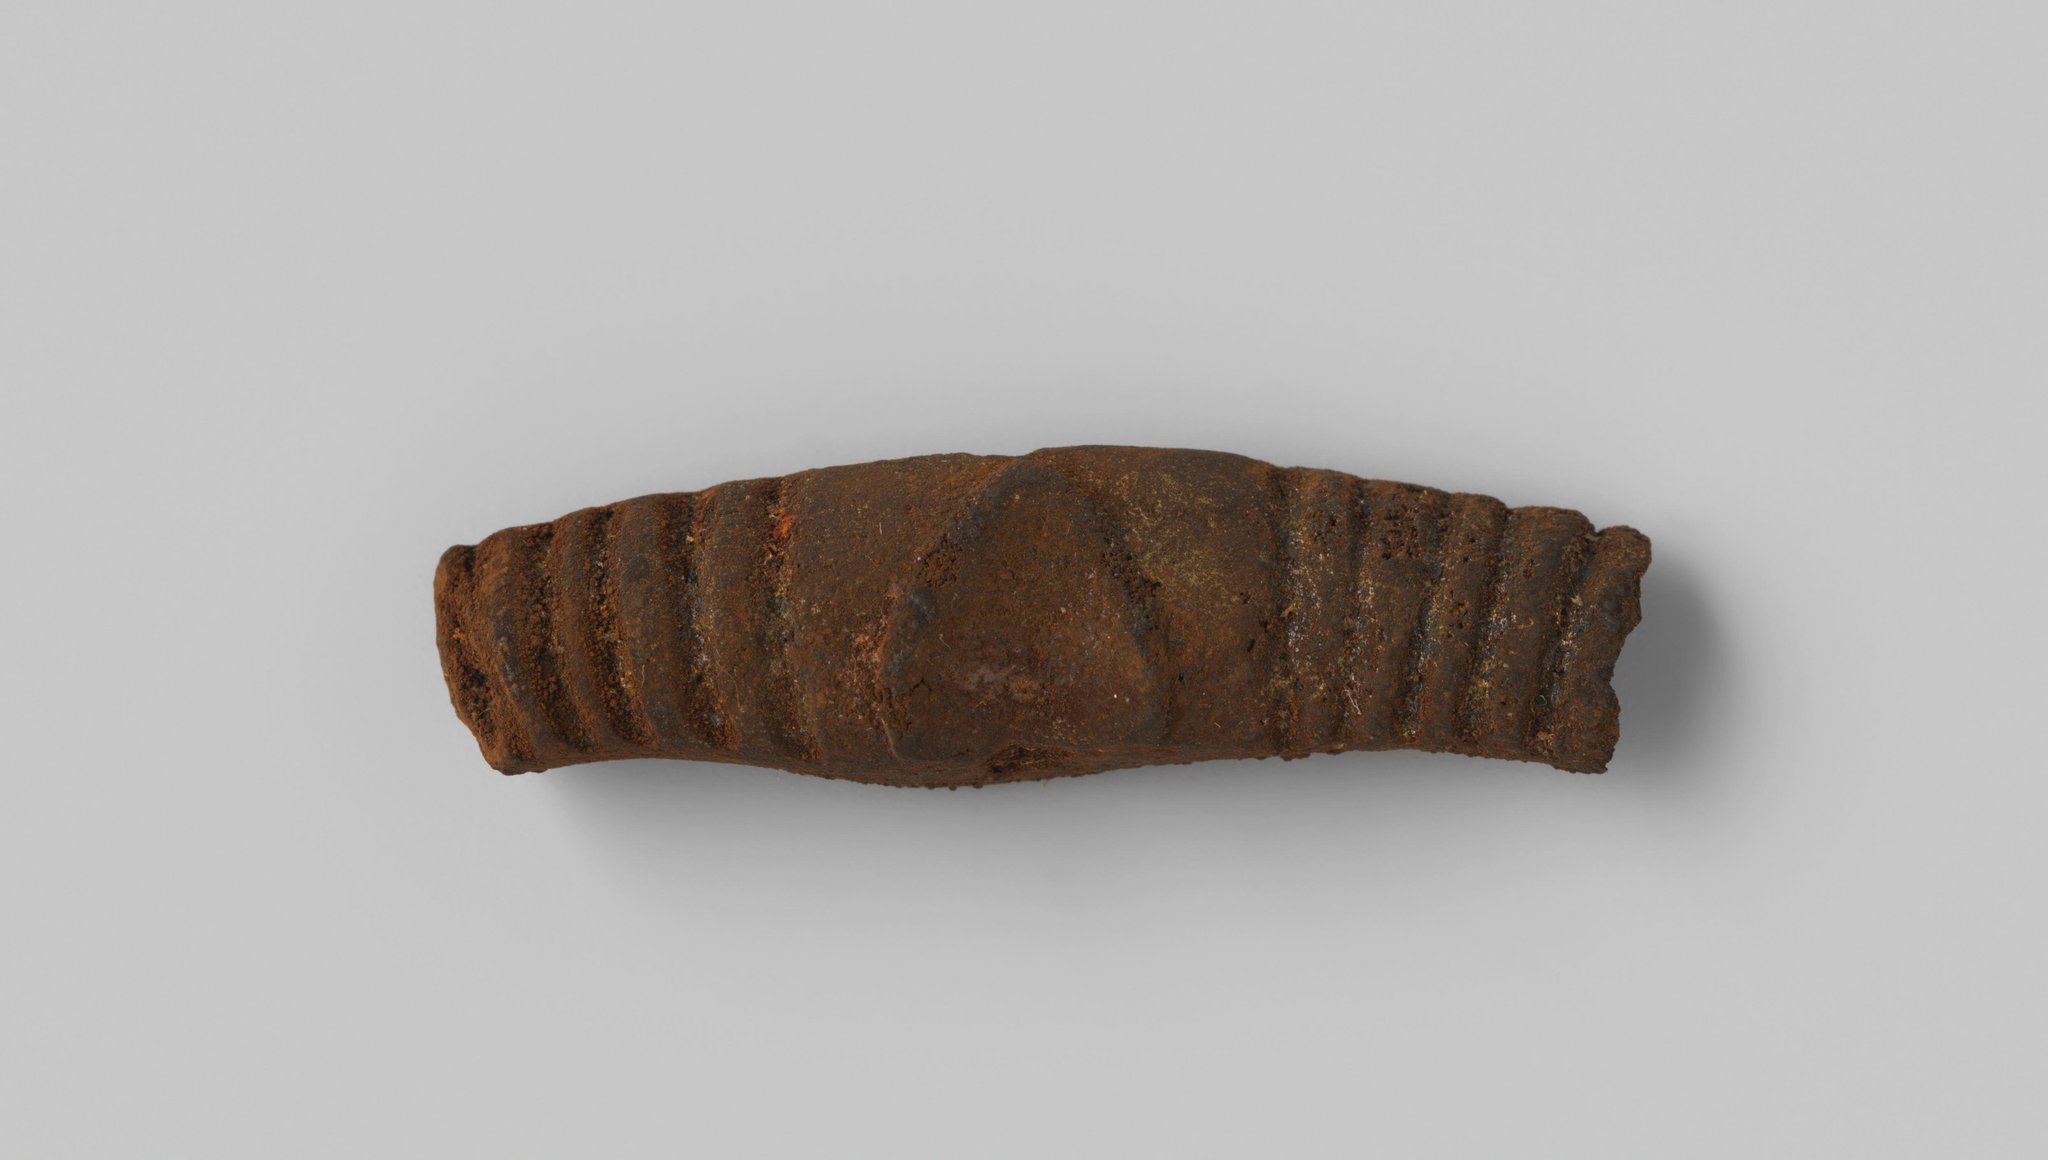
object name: buckle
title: Fragment van een gesp uit het wrak van de Oost-Indiëvaarder Hollandia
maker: Anonymous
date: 1700-1743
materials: copper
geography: netherlands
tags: verenigde oostindische compagnie, hollandia (schip), annet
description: Buckle, not identifiable; fragm of ring with spindle eye, linear decoration.